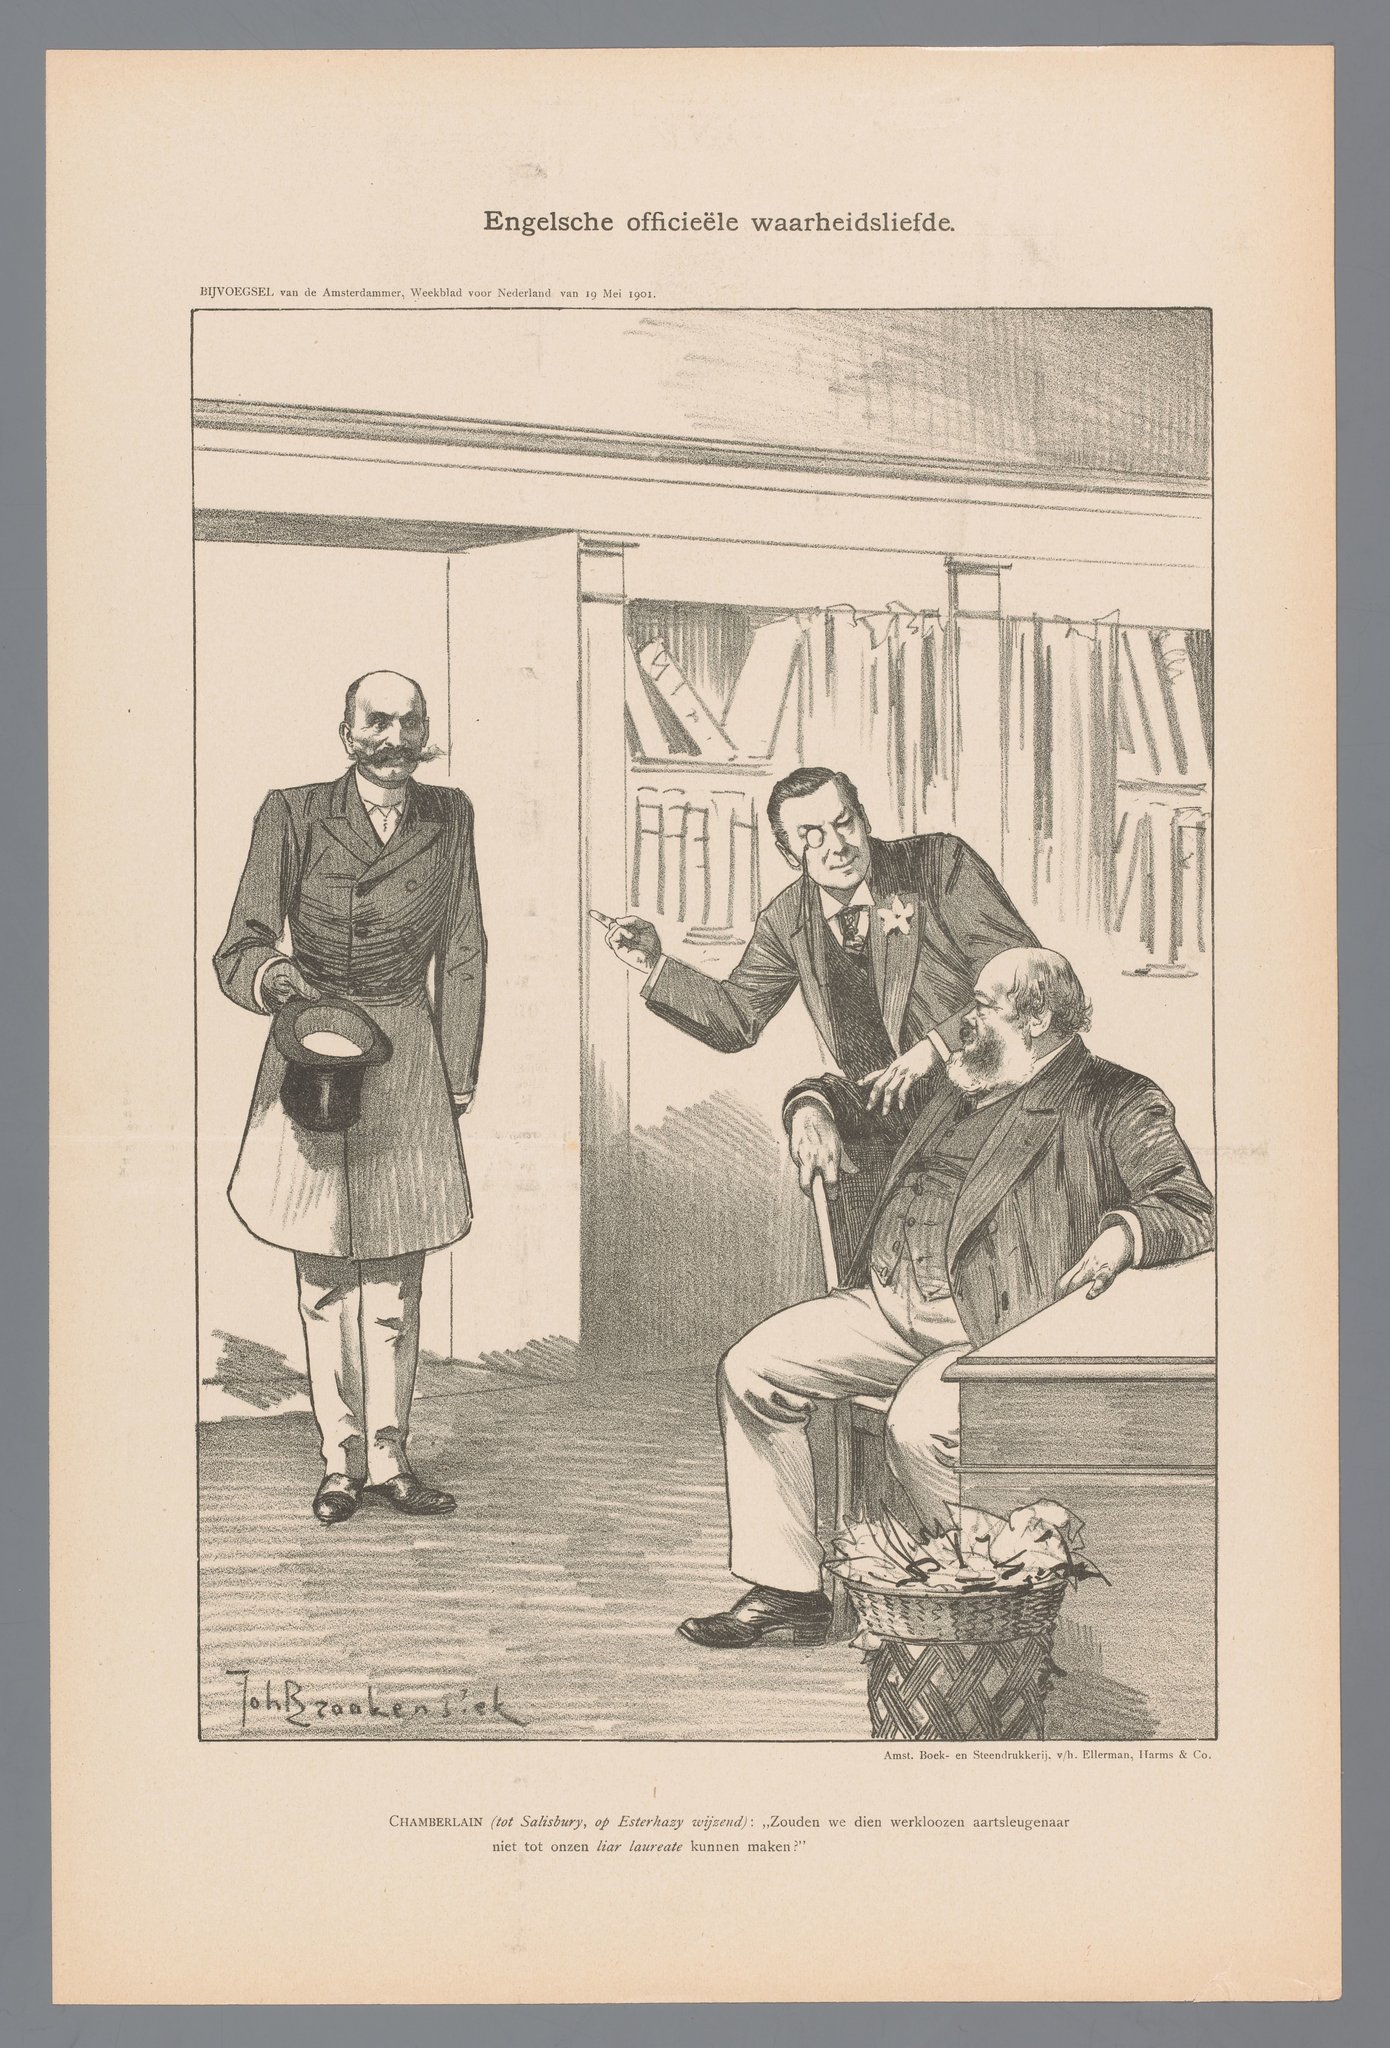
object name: cartoon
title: Engelsche officieële waarheidsliefde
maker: johan braakensiek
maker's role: draughtsman, print maker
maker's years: 1858-1940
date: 1901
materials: paper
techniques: lithograph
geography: amsterdam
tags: politician, historical persons, political caricatures and satires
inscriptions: date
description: Prent uit het bijvoegsel van: De Amsterdammer. Weekblad voor Nederland, 19 mei 1901.